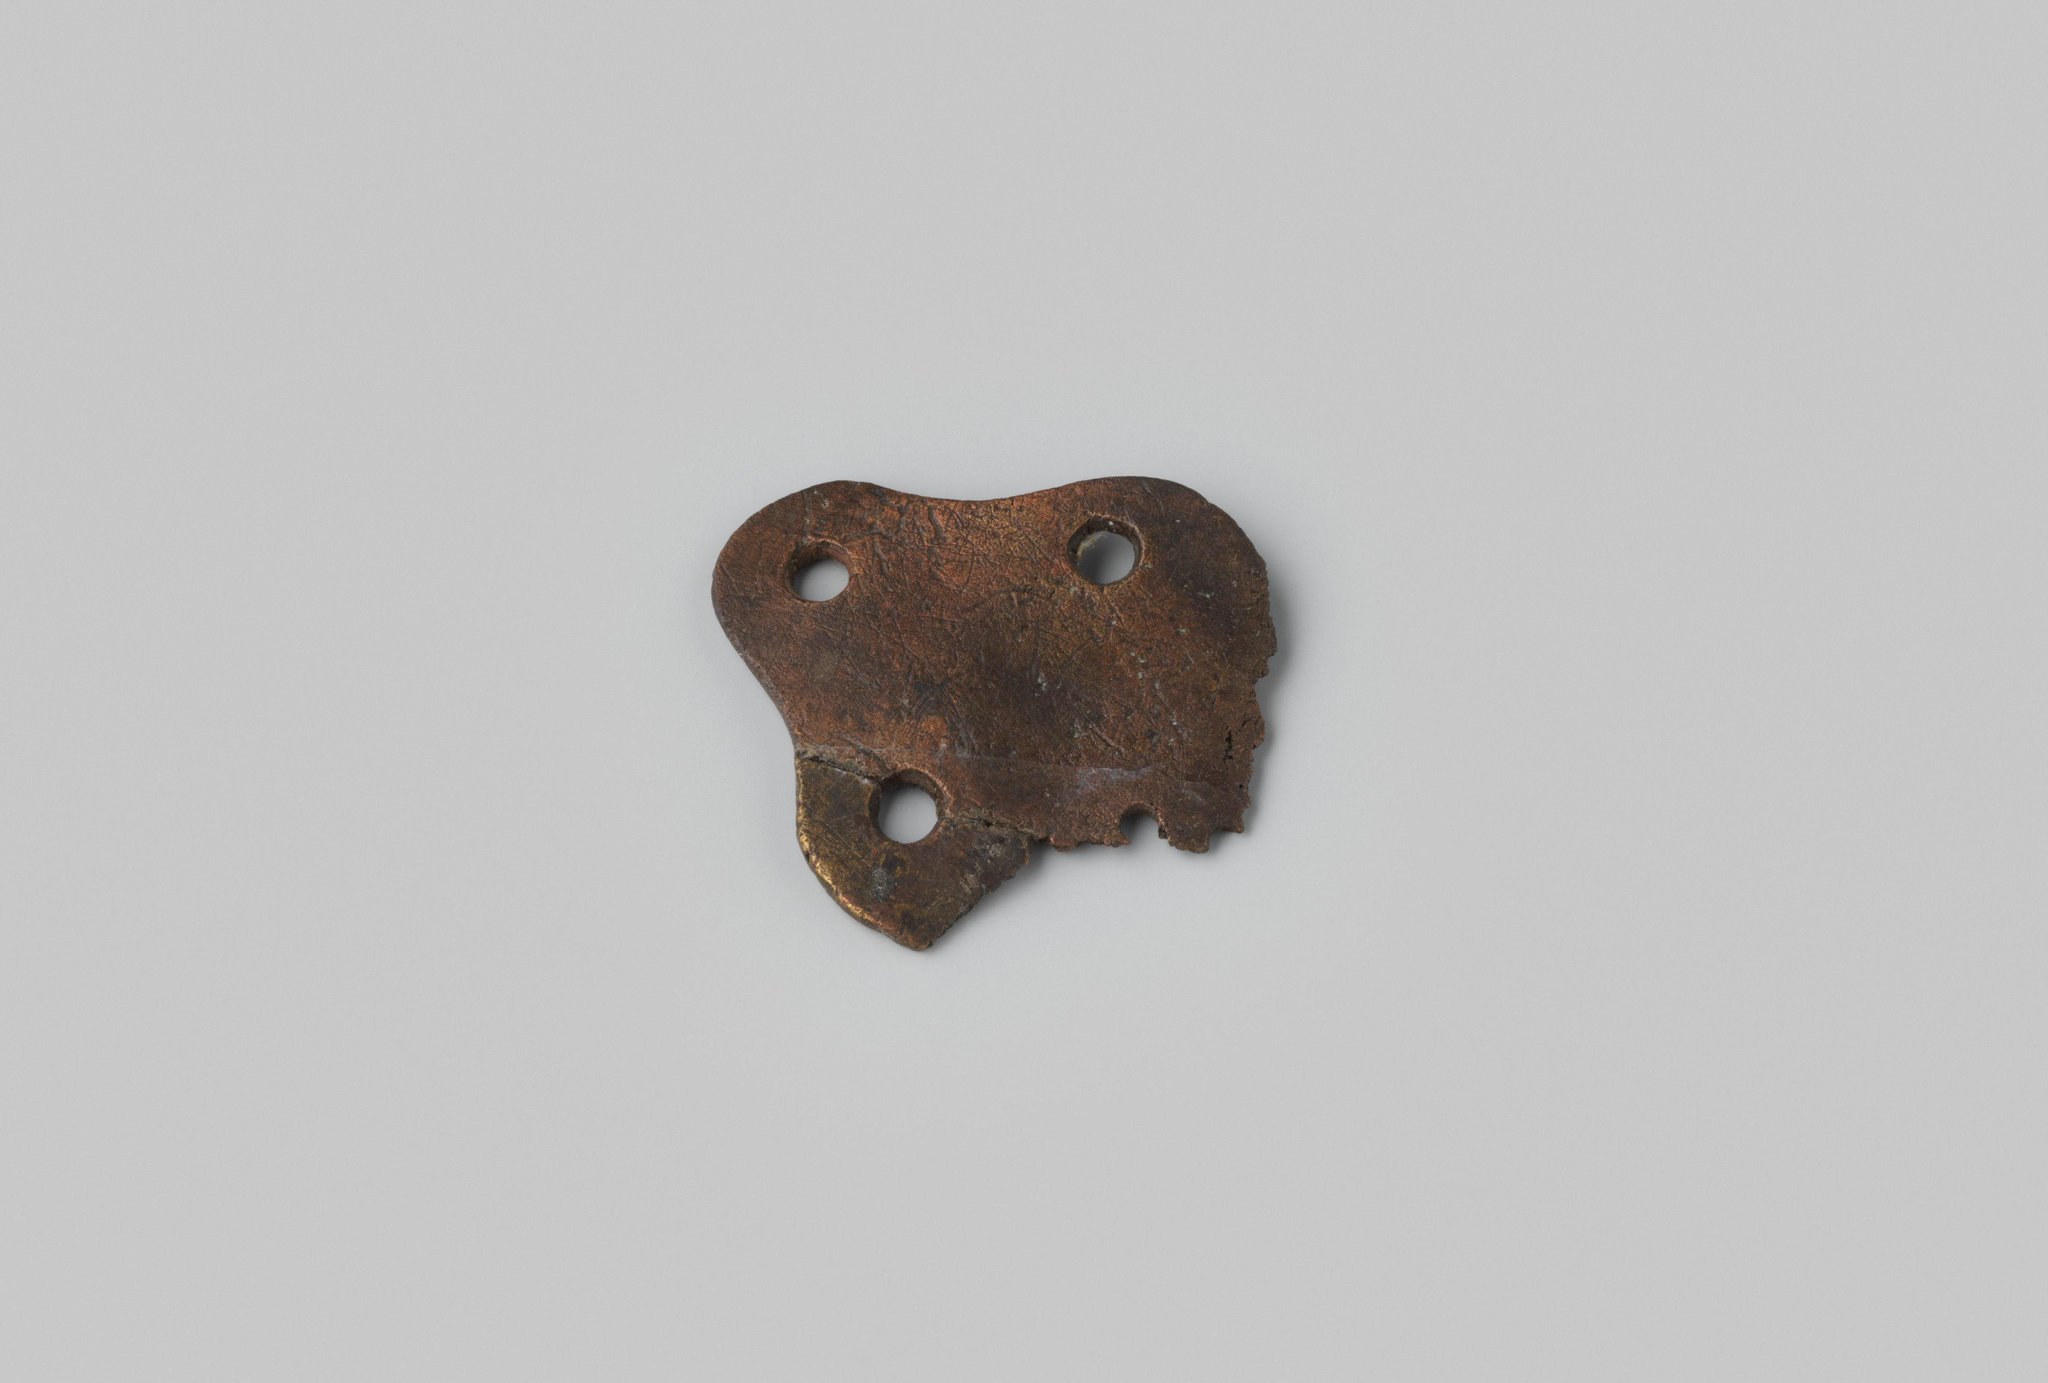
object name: lock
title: Deel van een slot uit het wrak van de Oost-Indiëvaarder Hollandia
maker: Anonymous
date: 1700-1743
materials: copper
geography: netherlands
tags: verenigde oostindische compagnie, hollandia (schip), annet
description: Locks, fastenings and accessories. lock: casings; fragm back-plate, id. NG 1980-27H560, three-lobed top.